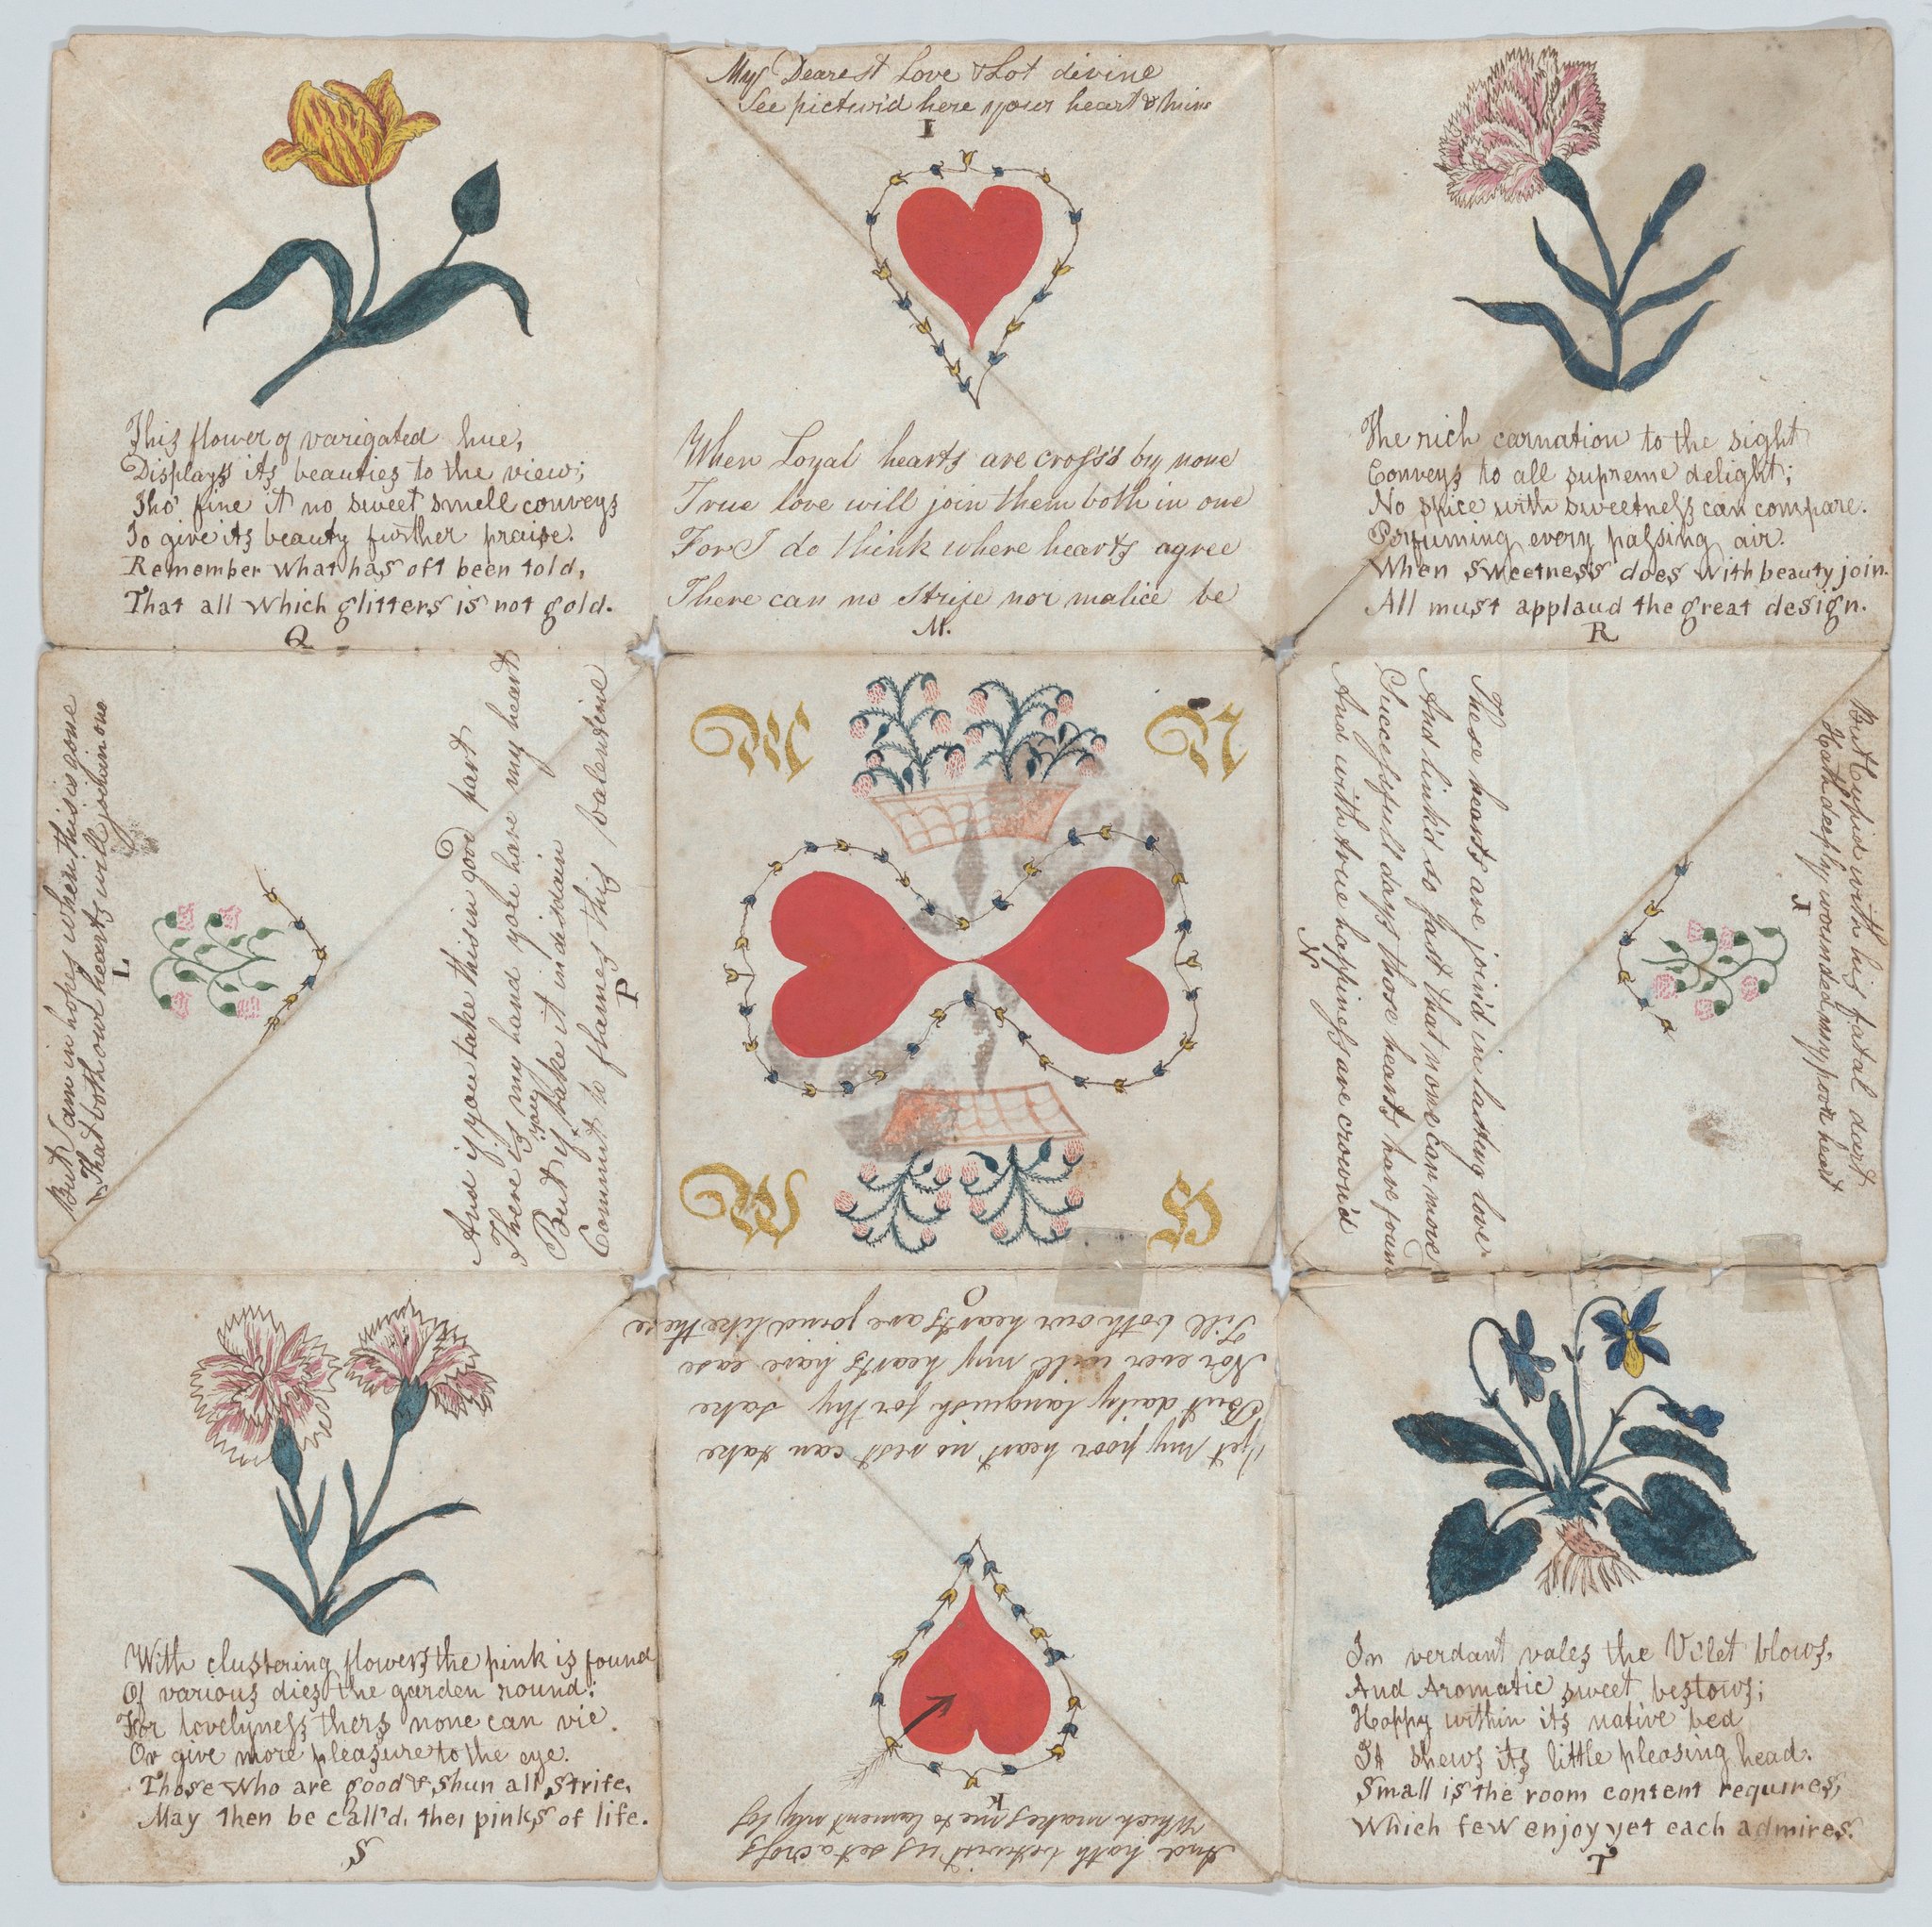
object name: valentine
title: Valentine: Puzzle Purse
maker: anonymous, british or american, 19th century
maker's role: artist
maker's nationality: british or american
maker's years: 1800-1900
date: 1826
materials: gold paint, watercolor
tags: flowers